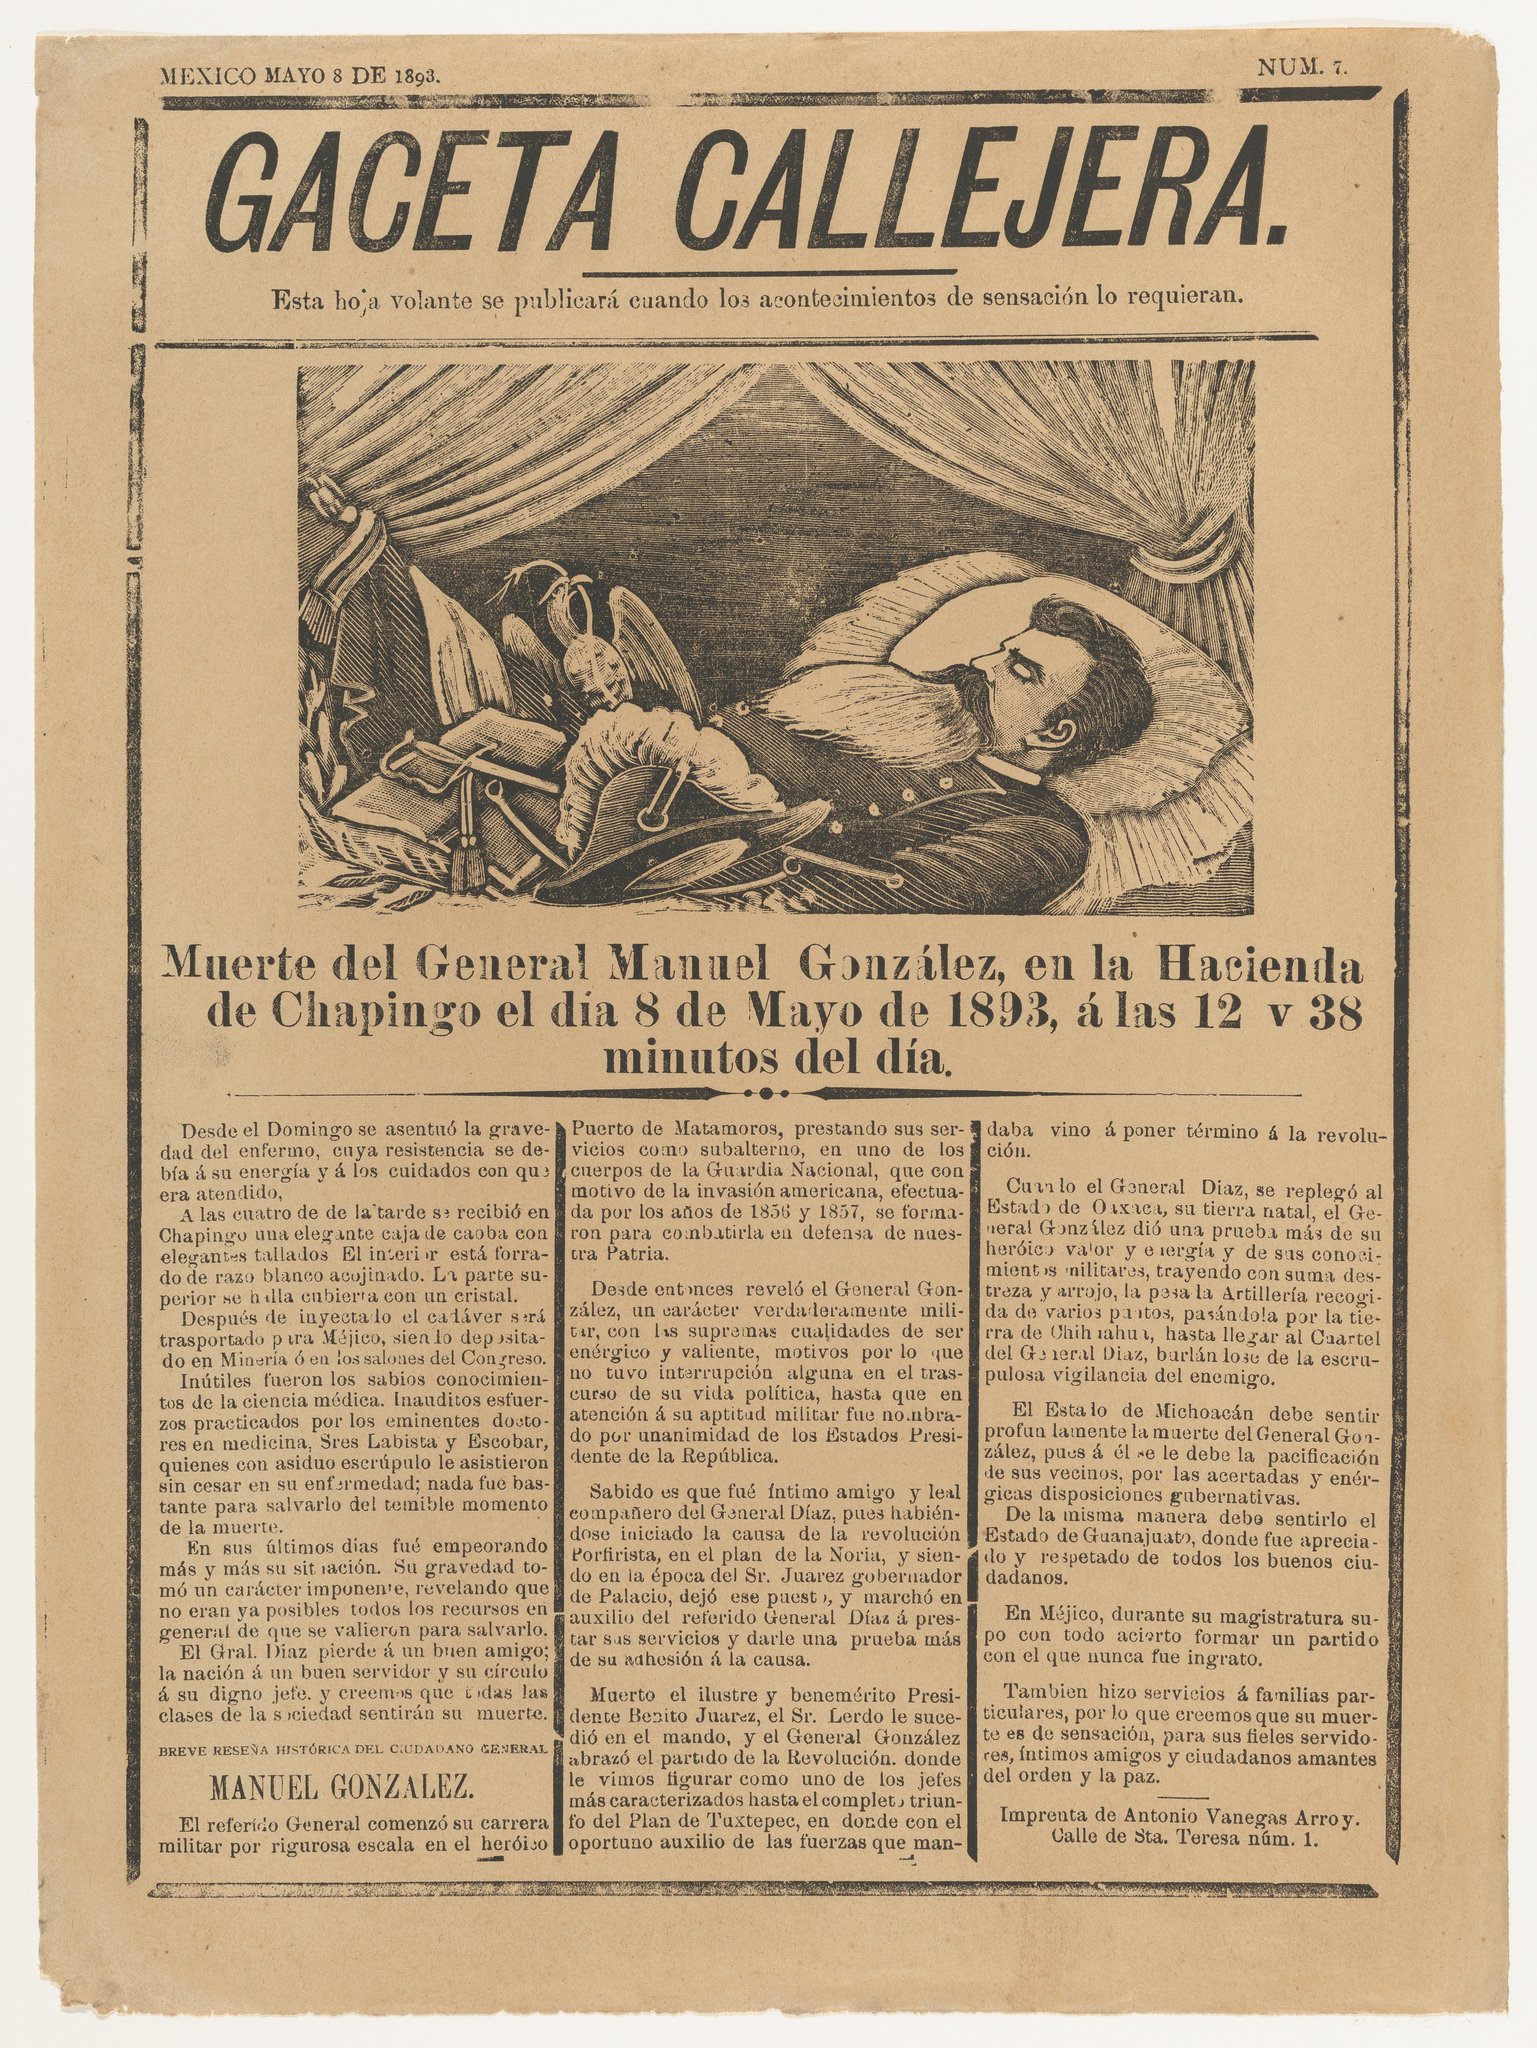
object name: print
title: Page (broadsheet) from the 'Gaceta Callejera' (street gazette) relating to the death of General González in Chapingo on May 8, 1893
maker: josé guadalupe posada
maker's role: artist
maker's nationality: mexican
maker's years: 1852-1913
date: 1893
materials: metal, paper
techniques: engraving, letterpress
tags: men,death,generals